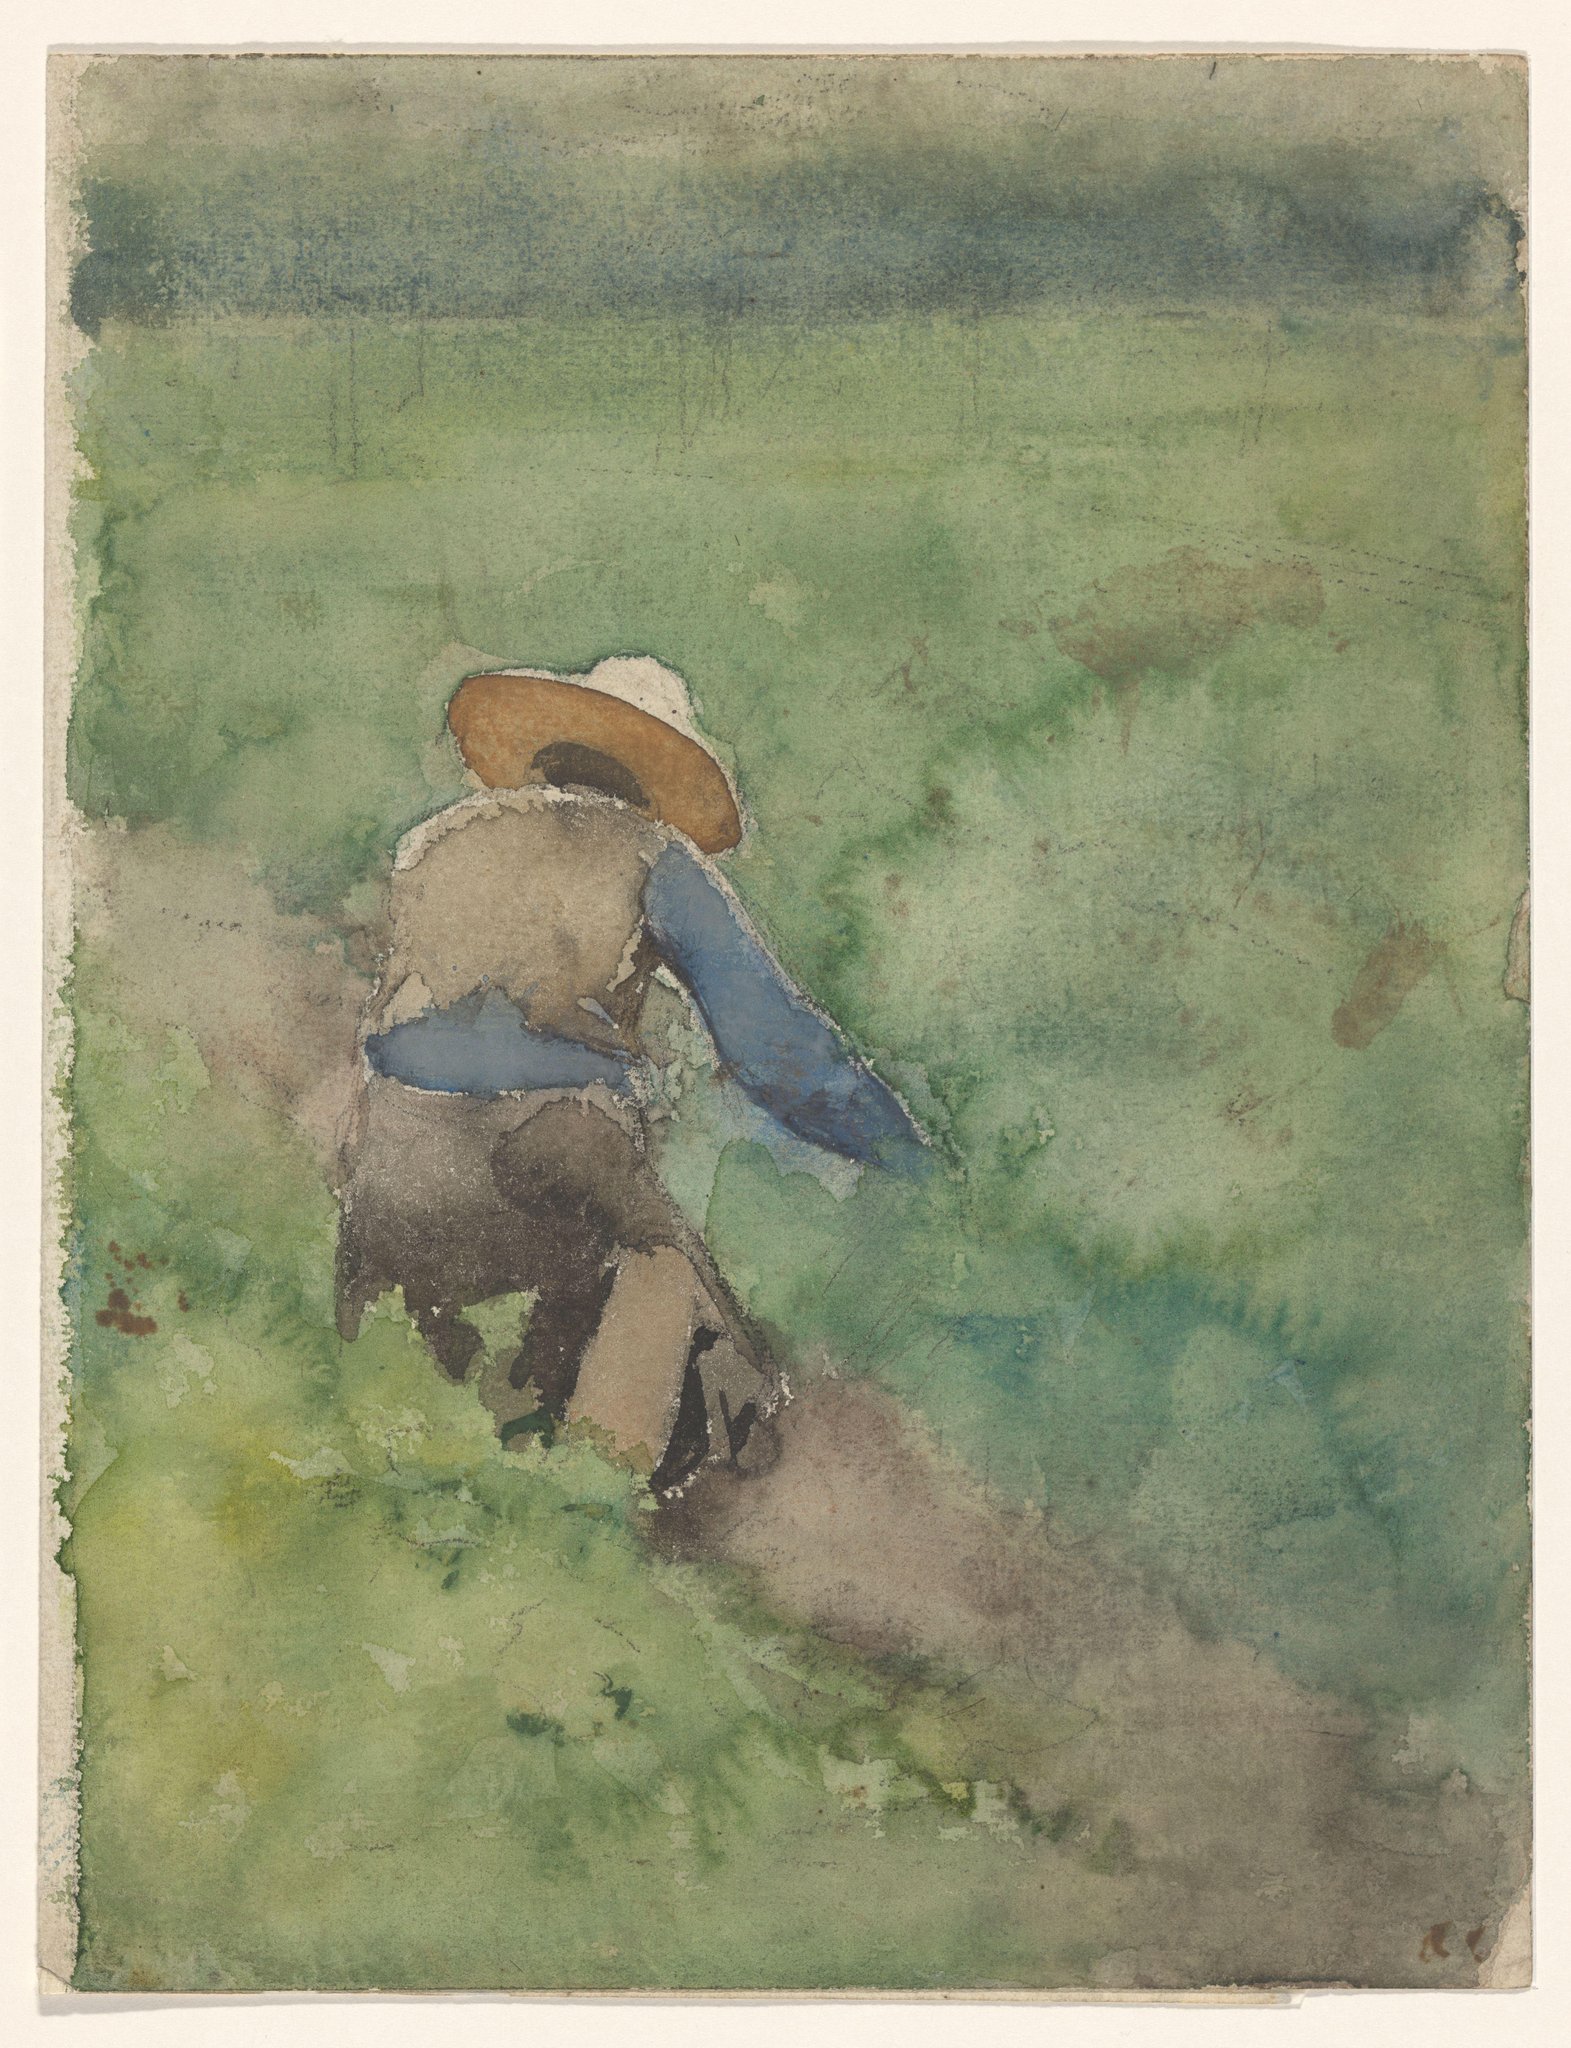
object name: drawing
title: Maaier in weiland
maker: willem witsen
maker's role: draughtsman, painter, print maker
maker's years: 1860-1923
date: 1870-1923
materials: chalk, paper, watercolor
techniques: brush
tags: head-gear: hat, reaping, picking, mowing ~ harvest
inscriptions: number: ‘T104’